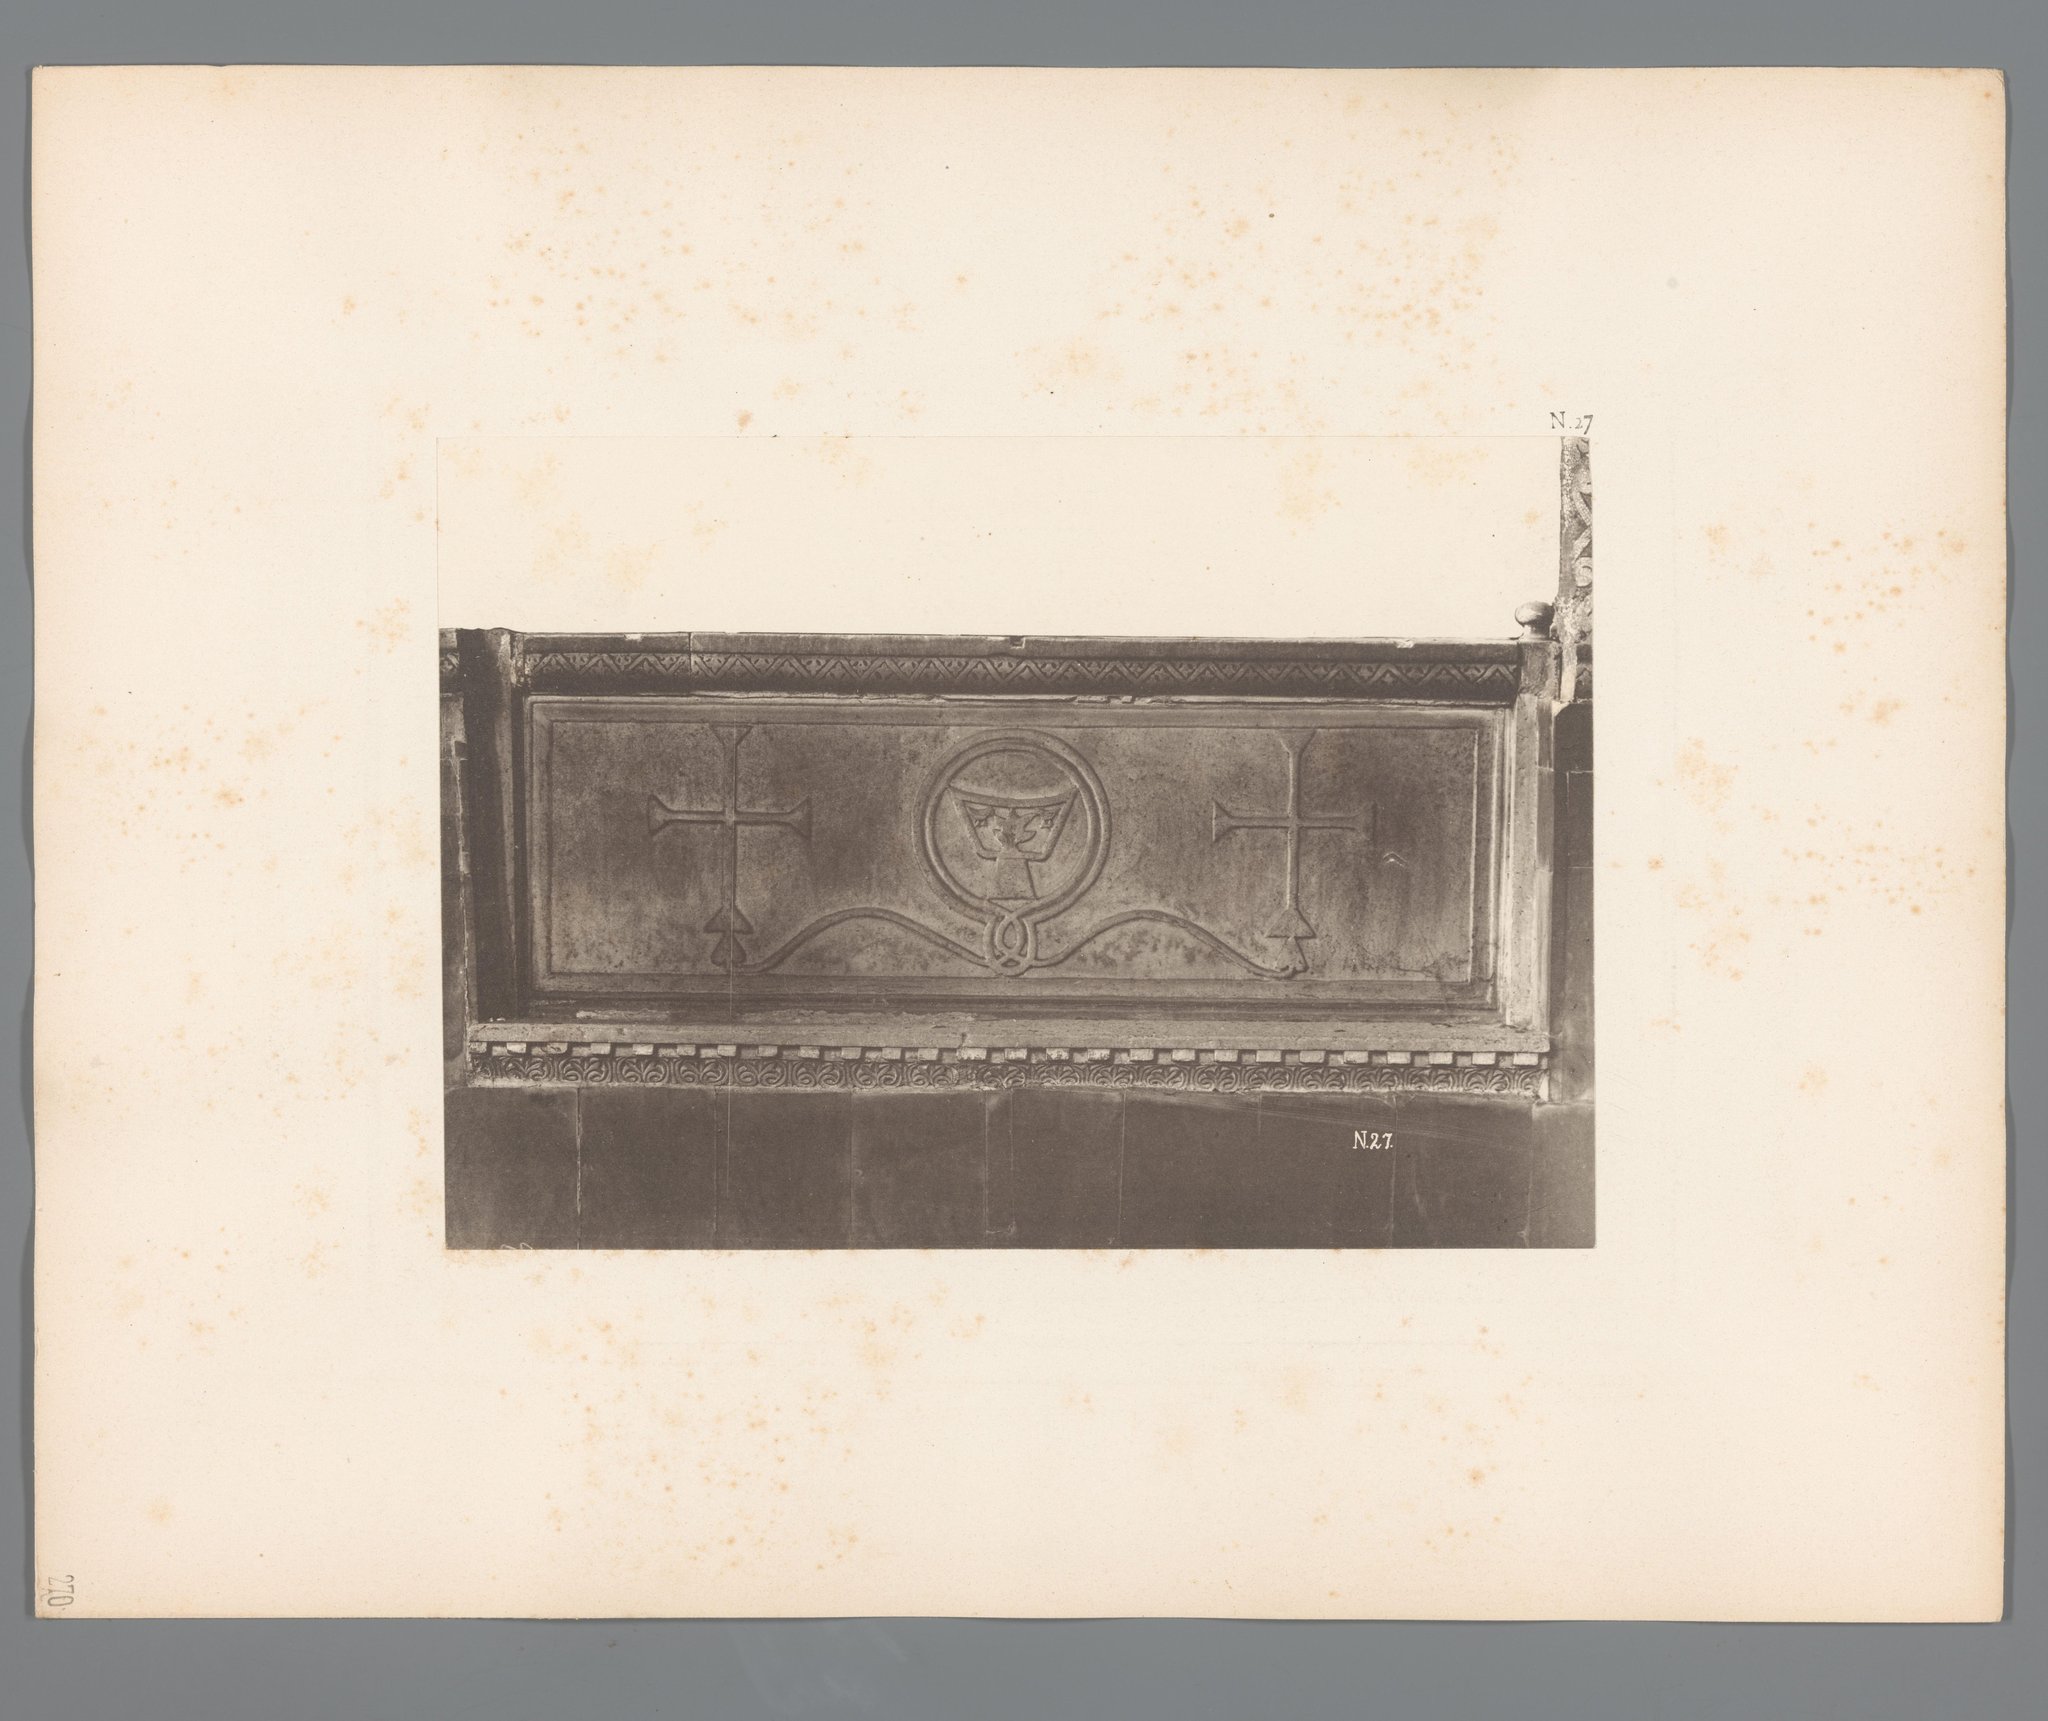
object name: photomechanical print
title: Balustrade met reliëf van de San Marco in Venetië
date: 1880-1885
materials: paper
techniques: photograph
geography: venice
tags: balustrade, piece of sculpture, reproduction of a piece of sculpture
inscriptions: number: ‘N.27.’, number: ‘N.27’, number: ‘270’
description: Deze prent maakt deel uit van een omslag met 58 prenten op 50 bladen.